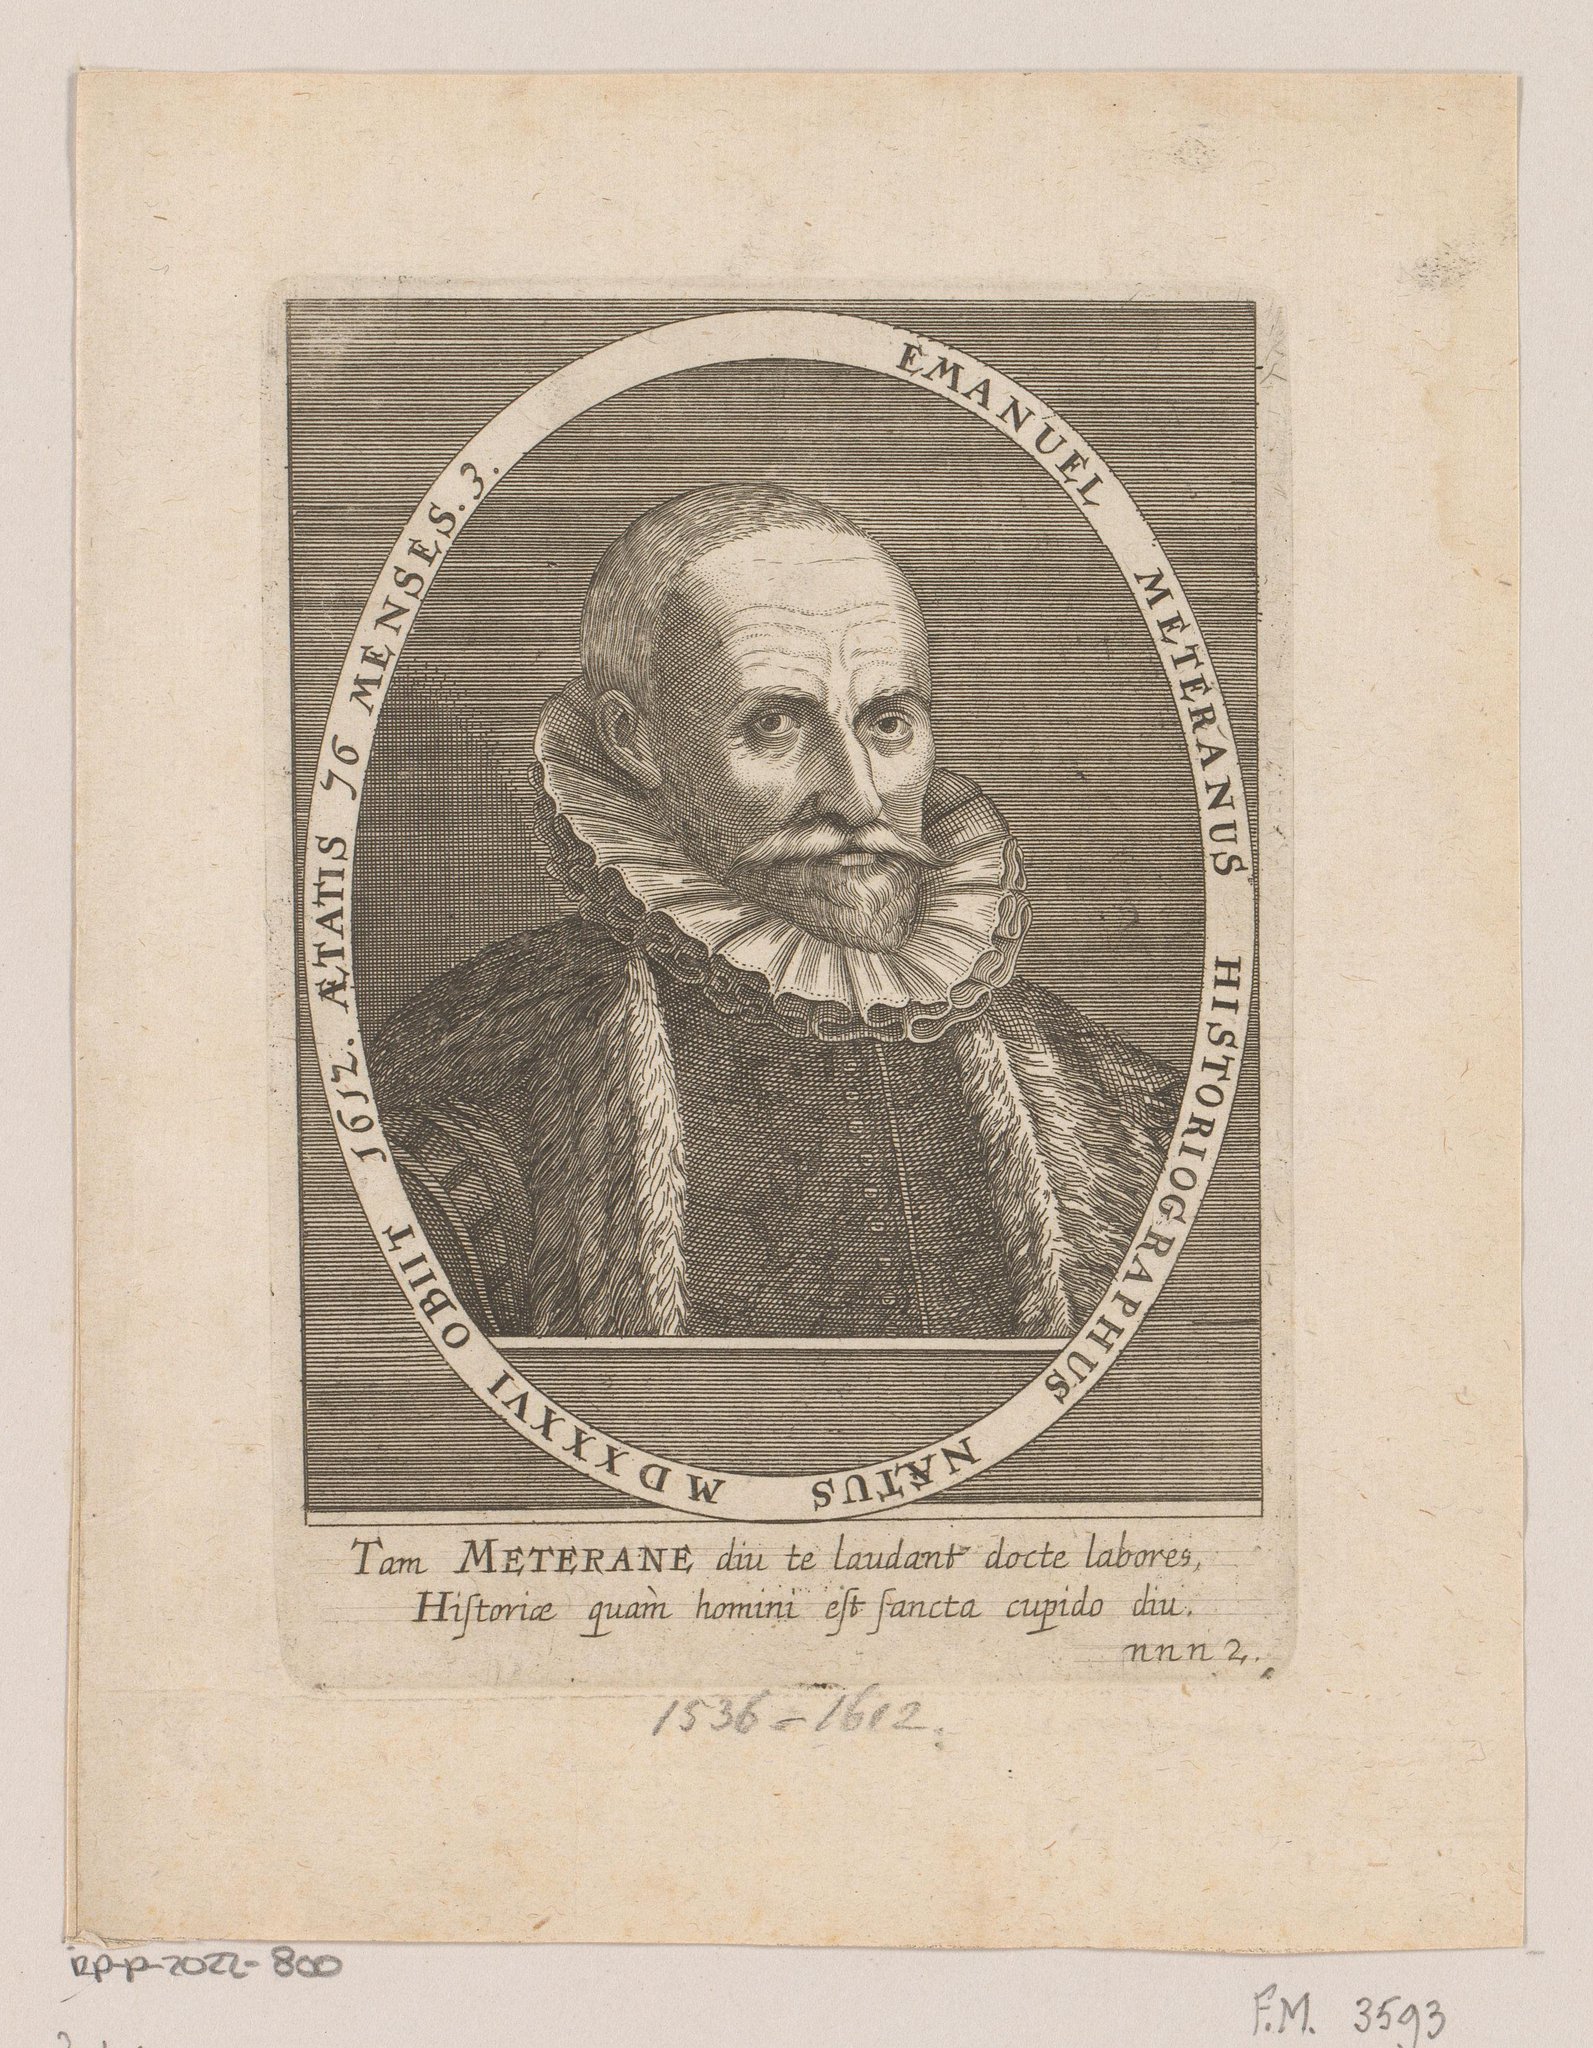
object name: book illustration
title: Portretten van geleerden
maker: Anonymous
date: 1652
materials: paper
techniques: engraving, etching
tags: antwerp, london, emanuel van meteren, historical persons, portrait of a writer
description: Prent waarschijnlijk uit: Boissard, Jean Jacques. Bibliotheca chalcographica (...) Frankfurt am Main: Johannes Ammon, 1652, dl. 8.